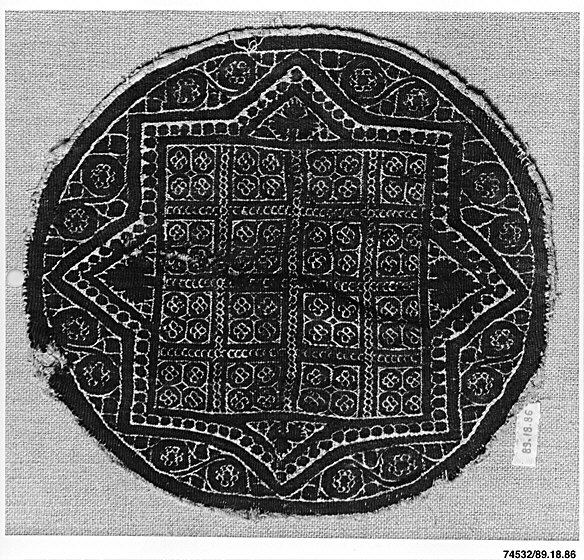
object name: textile fragment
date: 201-400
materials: linen, wool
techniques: weave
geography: egypt